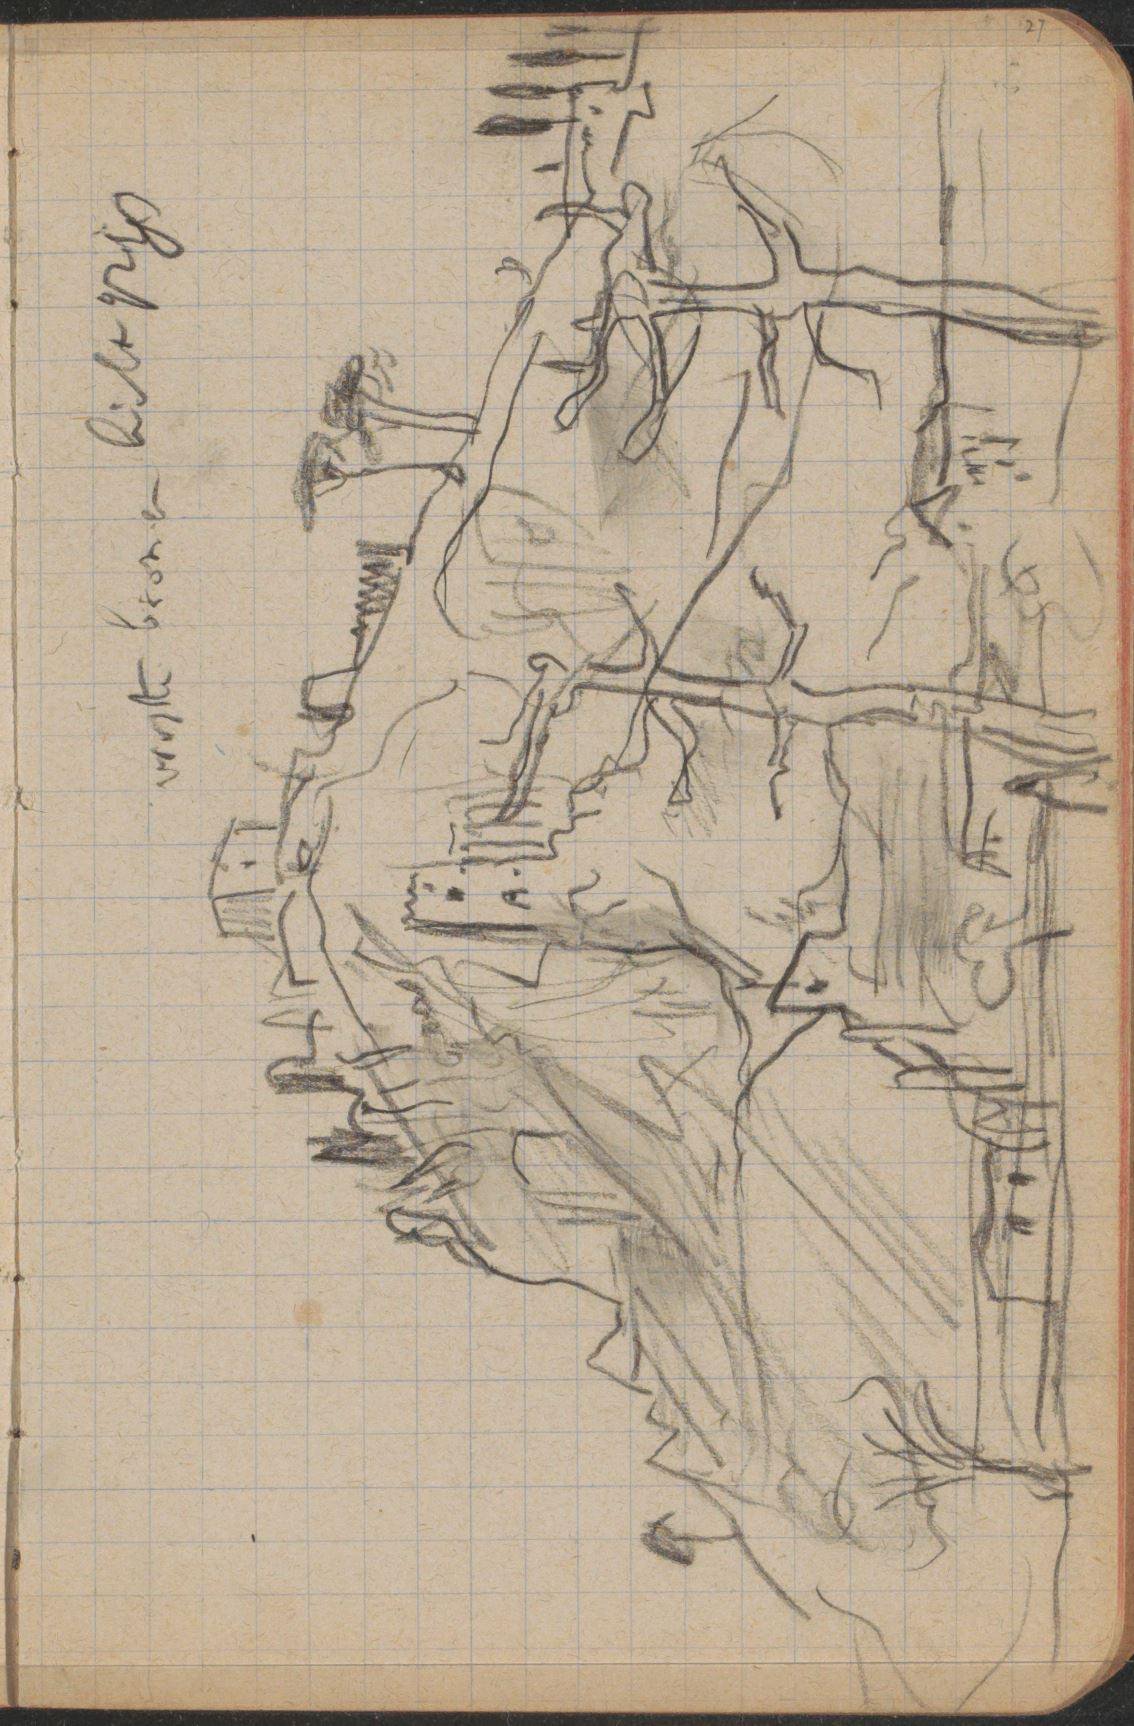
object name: sketchbook leaf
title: Landschap met gebouwen op een heuvel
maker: marius bauer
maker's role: draughtsman, print maker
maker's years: 1867-1932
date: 1895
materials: chalk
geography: italy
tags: city-view, and landscape with man-made constructions, trees, (high) hill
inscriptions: kleurnotitie, handgeschreven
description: Een trap leidt naar de top van de heuvel. Pagina 27 uit een schetsboek met 28 bladen.